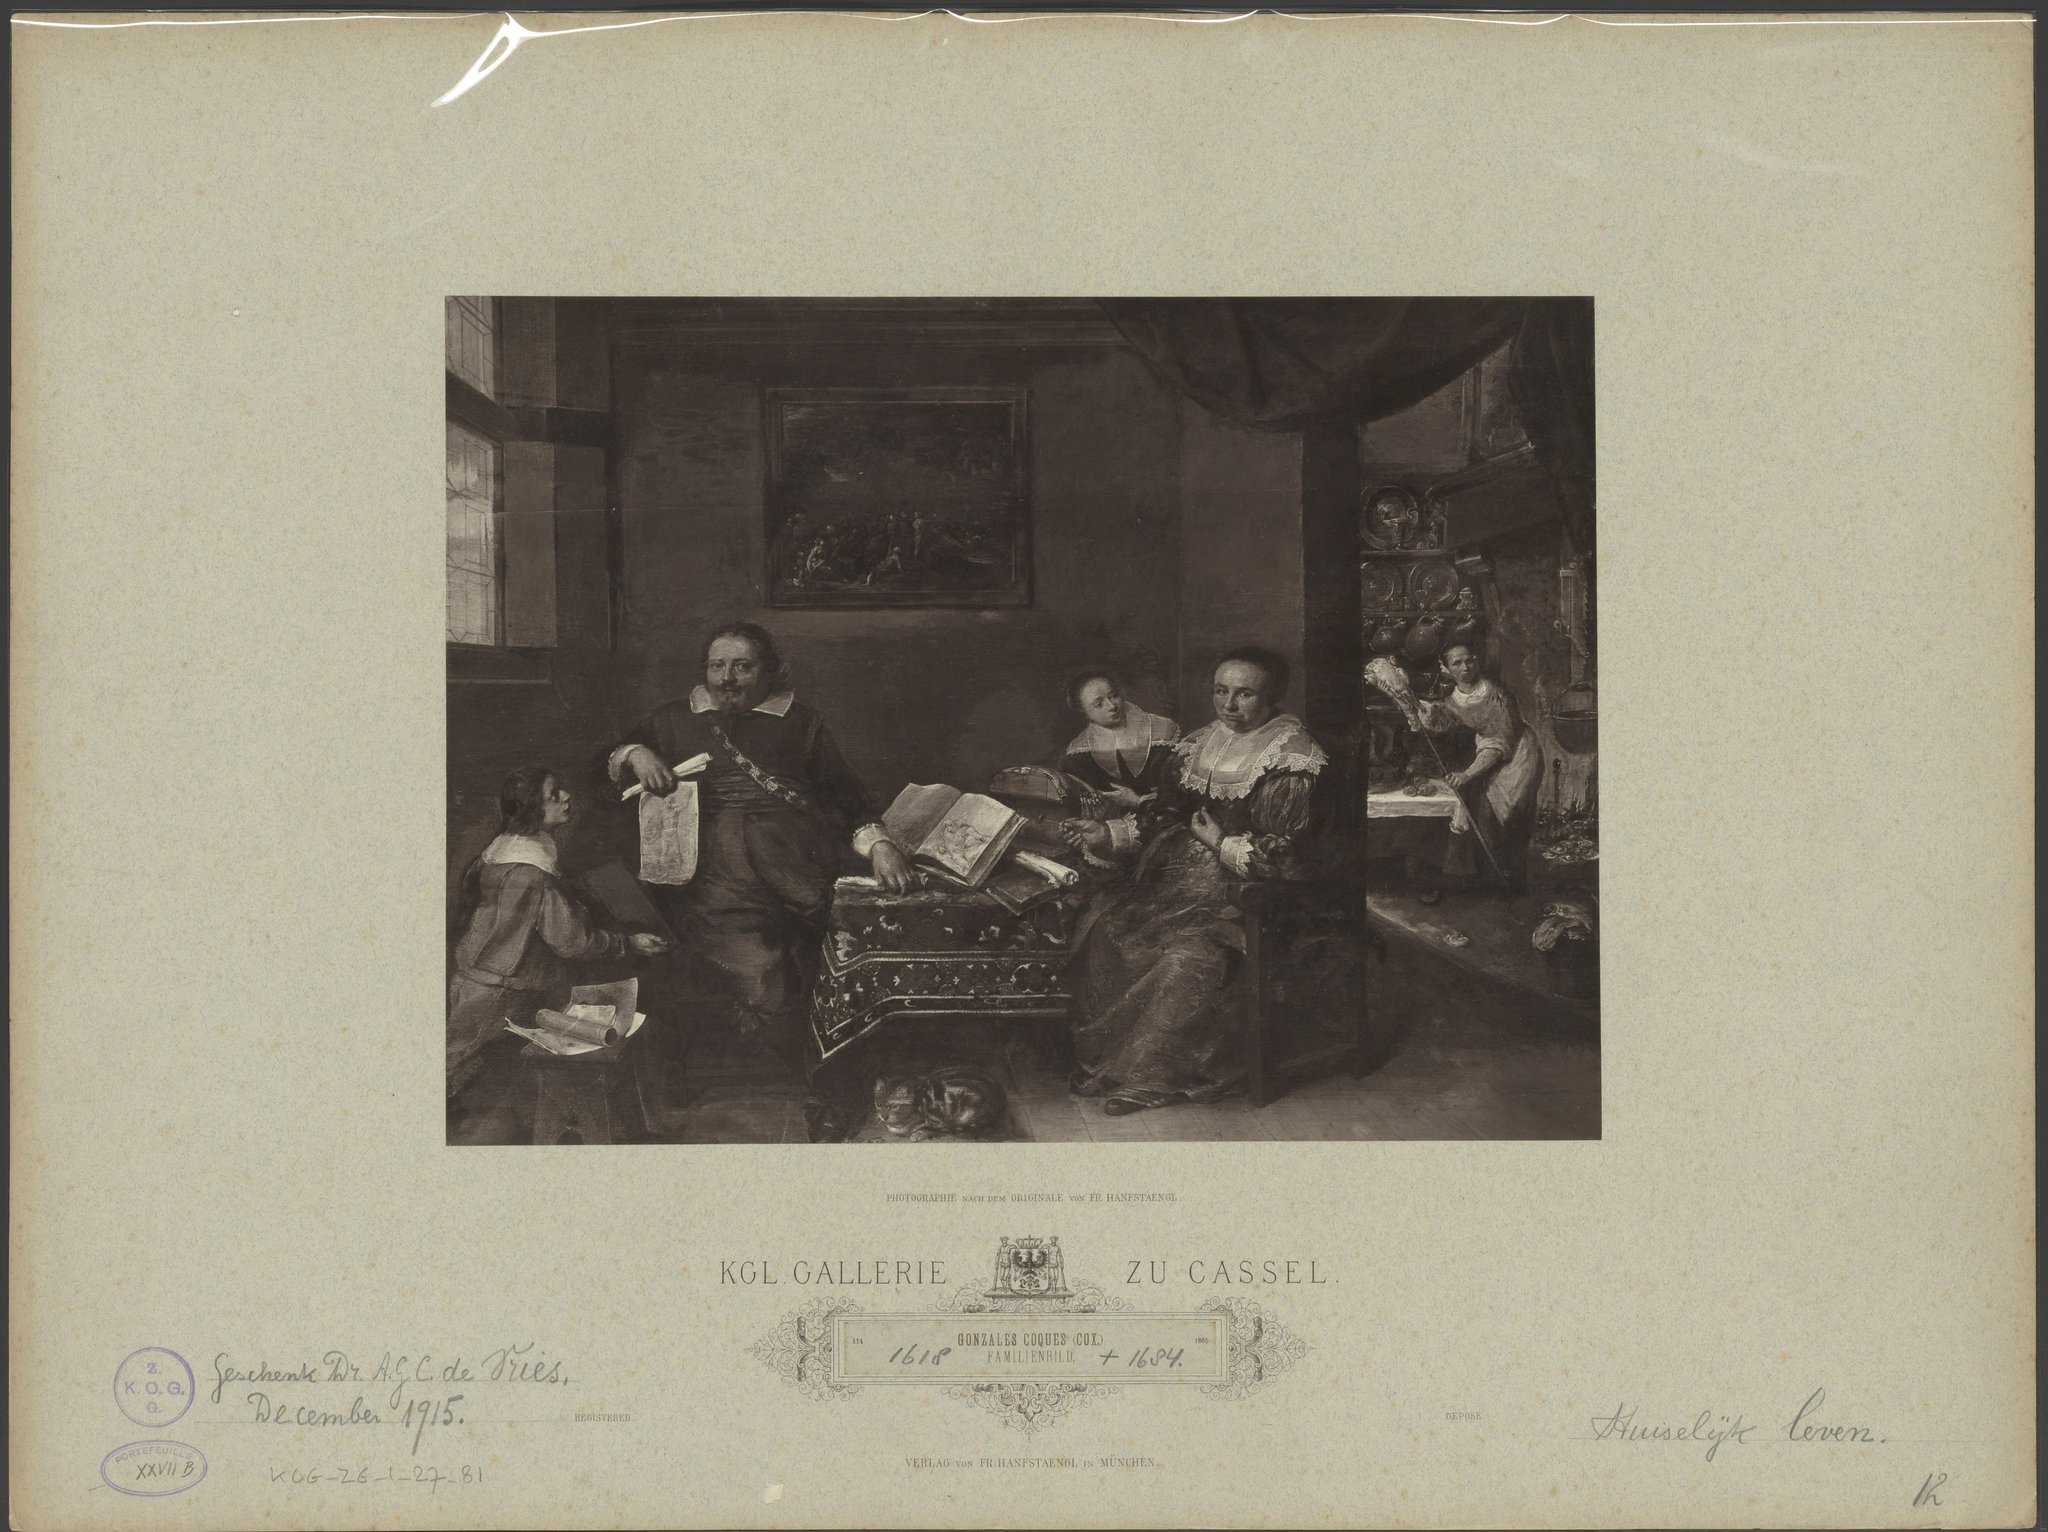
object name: photograph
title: Gonzales Coques (Cox.) Familienbild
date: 1885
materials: cardboard, photographic support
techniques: carbon print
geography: munich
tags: antwerp, painter, draughtsman, gonzales coques, drawing, lace-making, interior of the house, family life at home, parental love, kitchen-maid, kitchen servant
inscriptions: collector's mark: Lugt 1641, collector's mark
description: Naar het schilderij in de collectie van de Hessen Kassel Heritage.